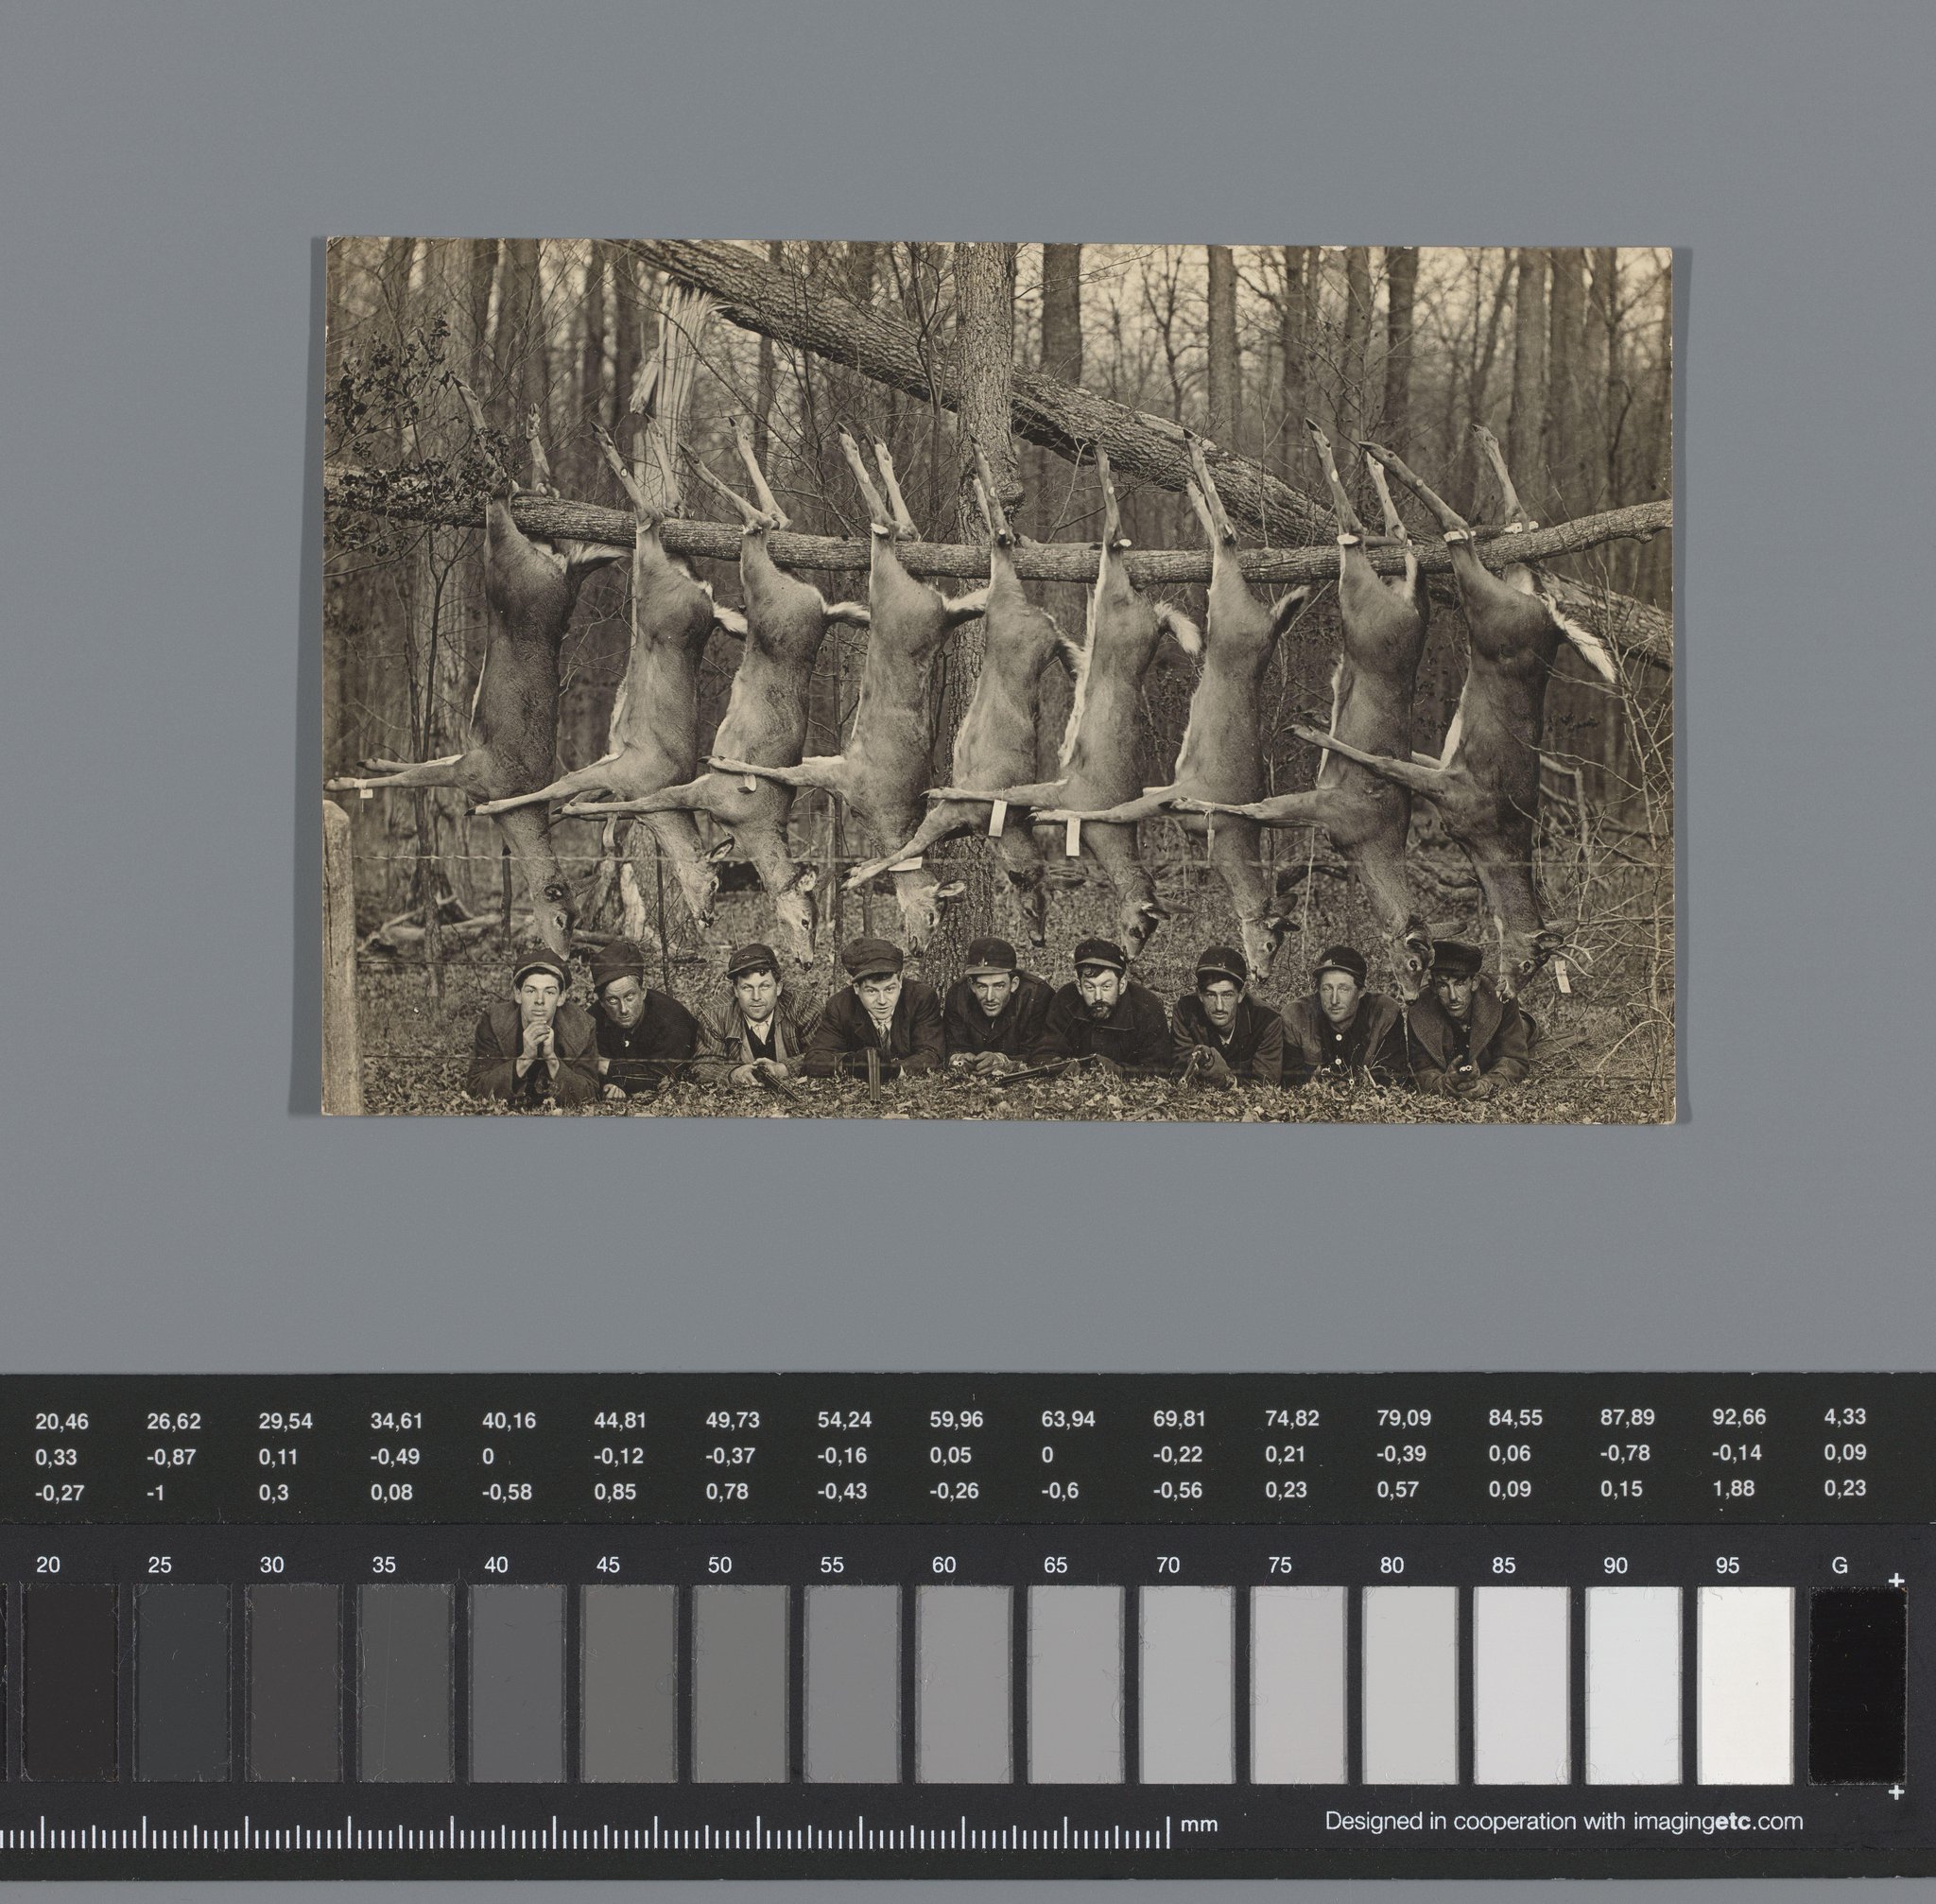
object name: ansichtkaart, prentbriefkaart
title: 9 Mannen en 9 dode herten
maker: Anonymous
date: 1907-1920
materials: photographic support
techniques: photography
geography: united states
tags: united states of america